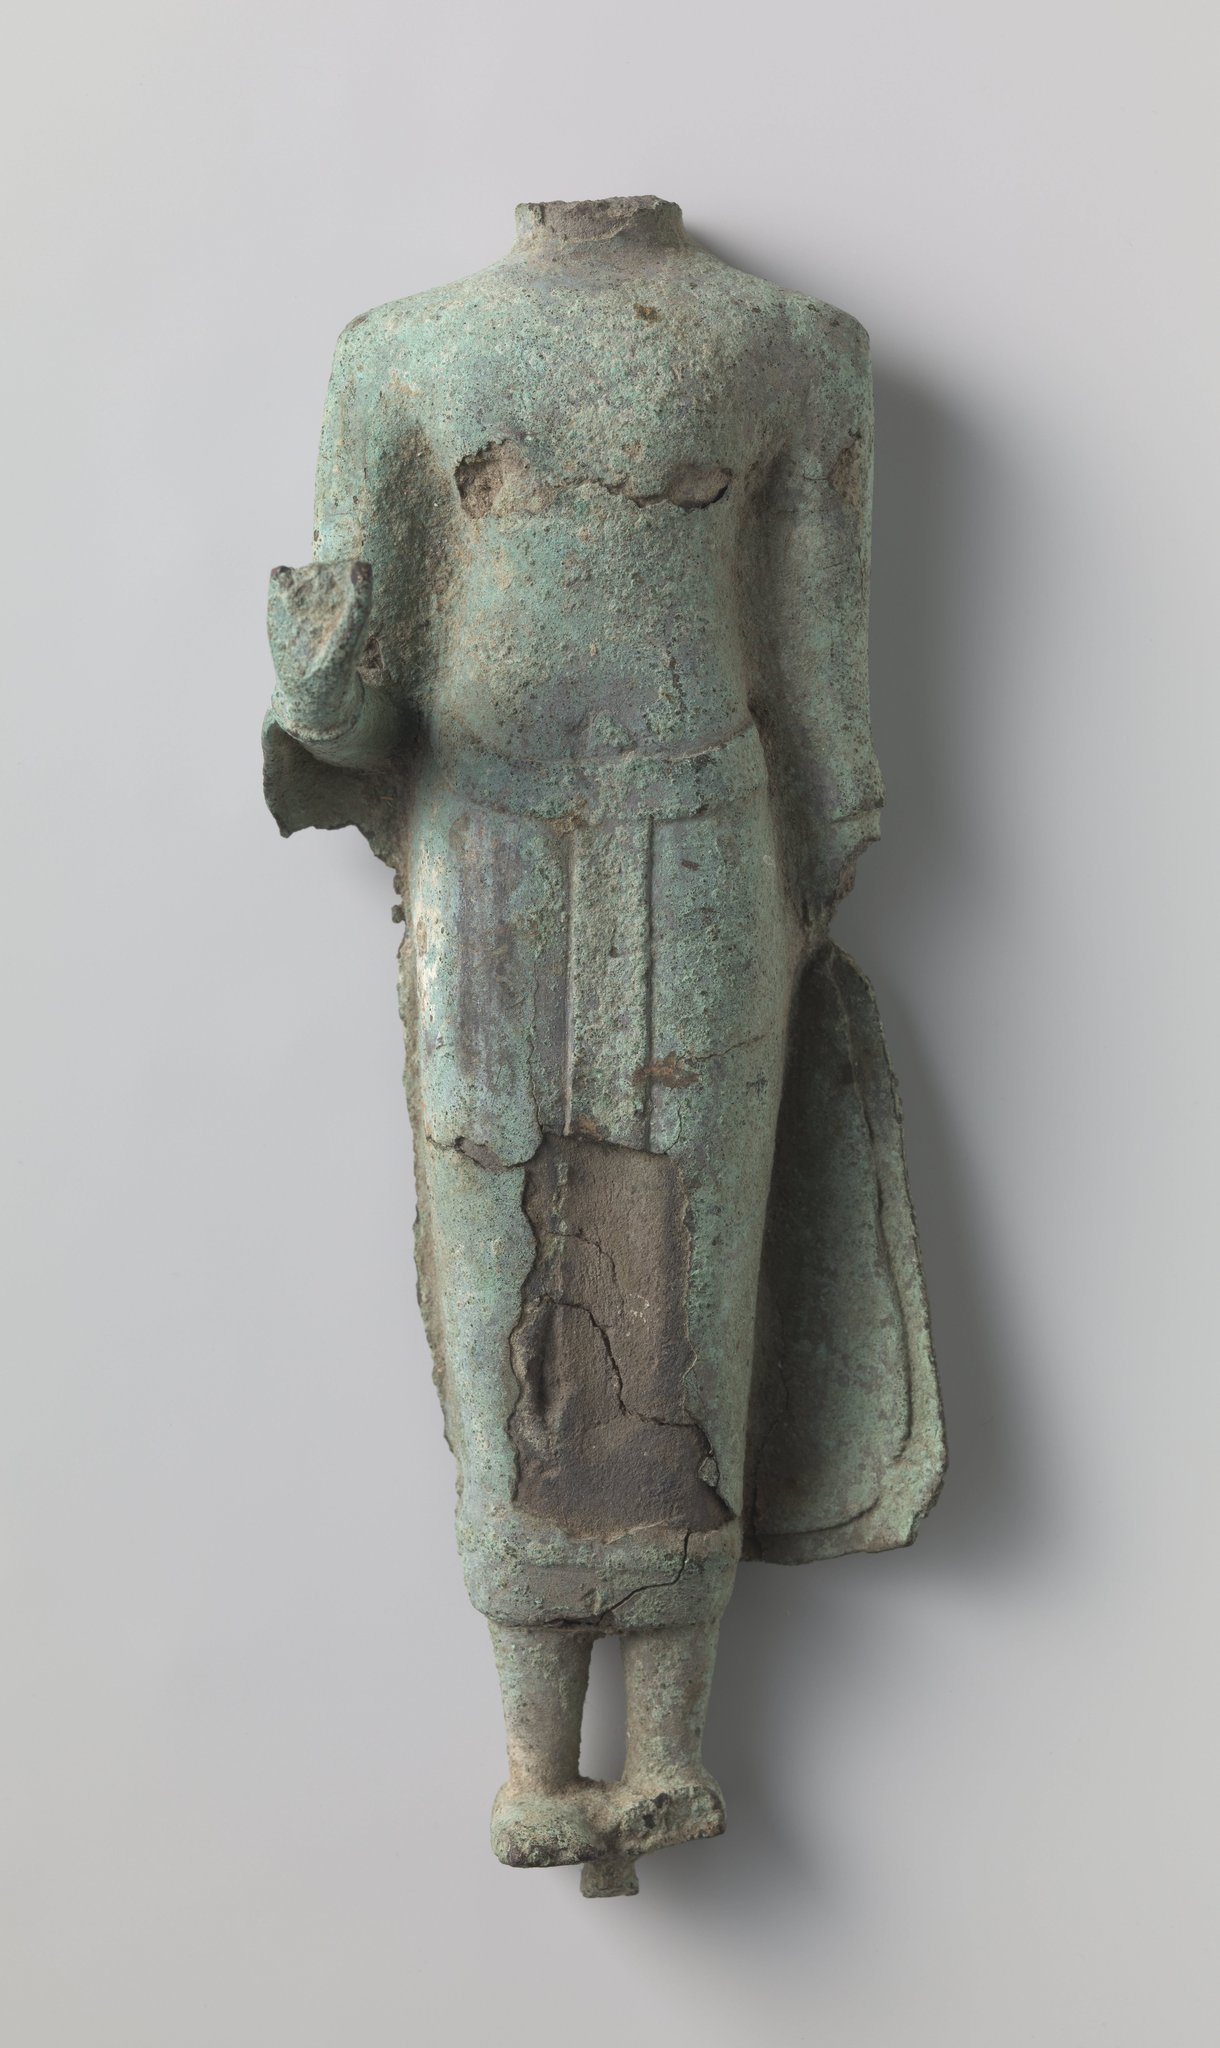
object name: bust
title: Fragment van een Boeddha-beeld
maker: Anonymous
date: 1600-1699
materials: bronze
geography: thailand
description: Buste van een Boeddha; het hoofd is afgebroken evenals de linkerhand en de vingers van de rechterhand.